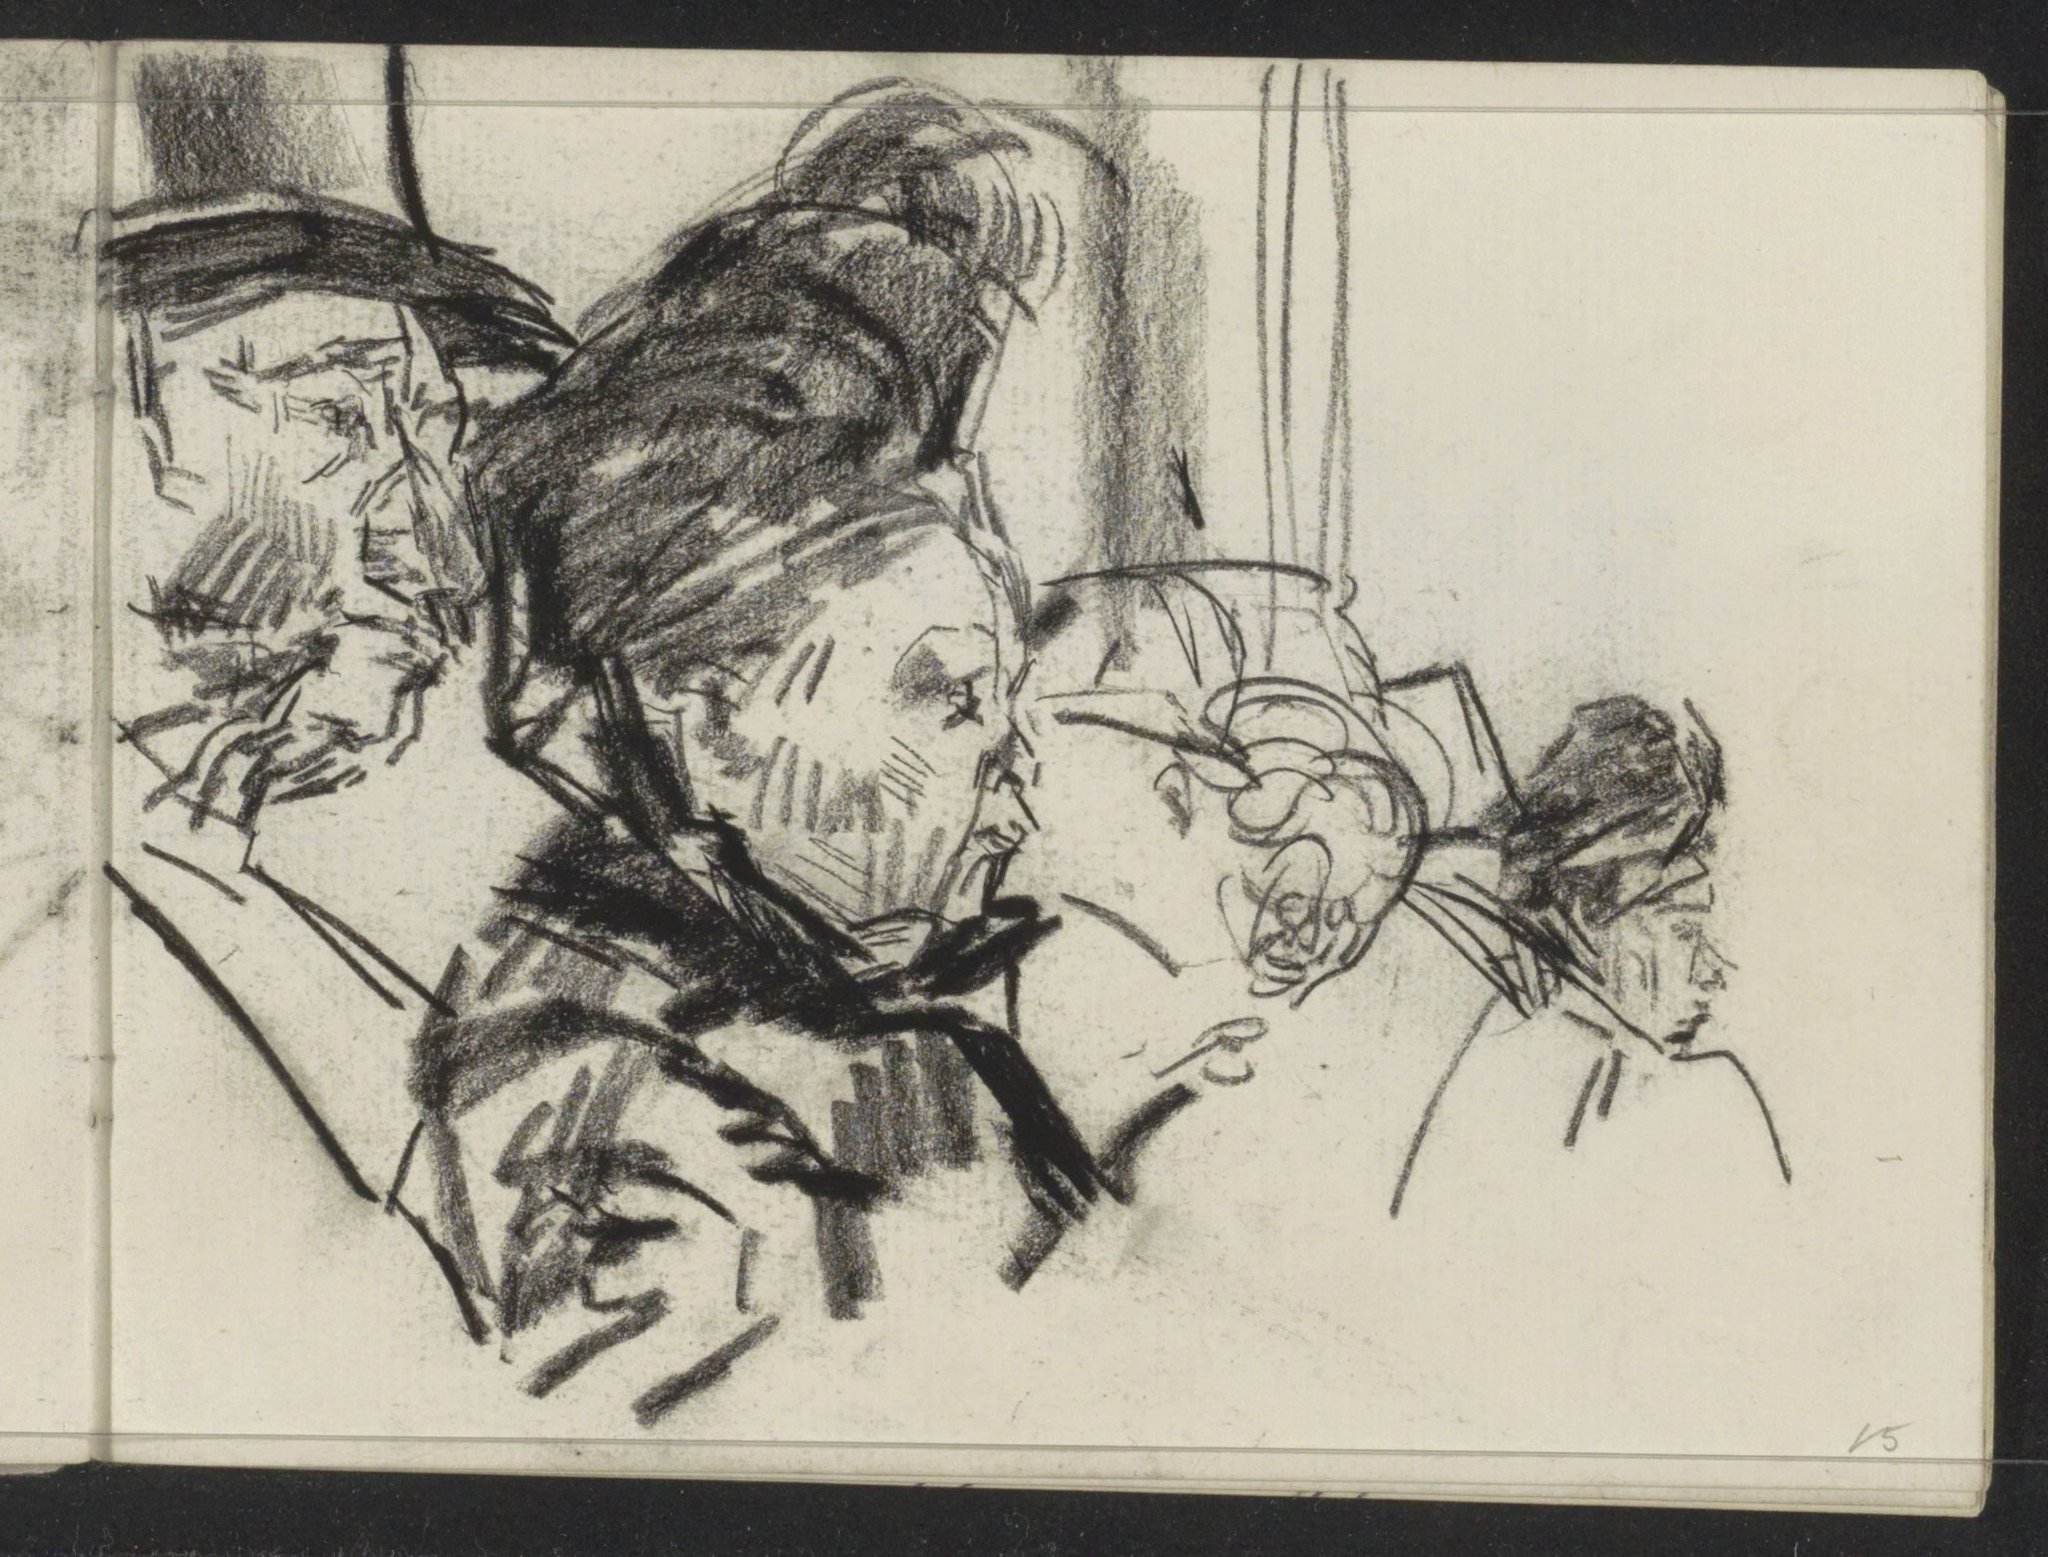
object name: sketchbook leaf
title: Mannen en vrouwen met hoeden, mogelijk toeschouwers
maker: isaac israels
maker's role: draughtsman, painter, print maker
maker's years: 1865-1934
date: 1886-1934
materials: chalk, paper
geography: amsterdam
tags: adult woman, adult man, the audience ~ art performance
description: Blad 15 recto uit schetsboek LXIV met 29 bladen.